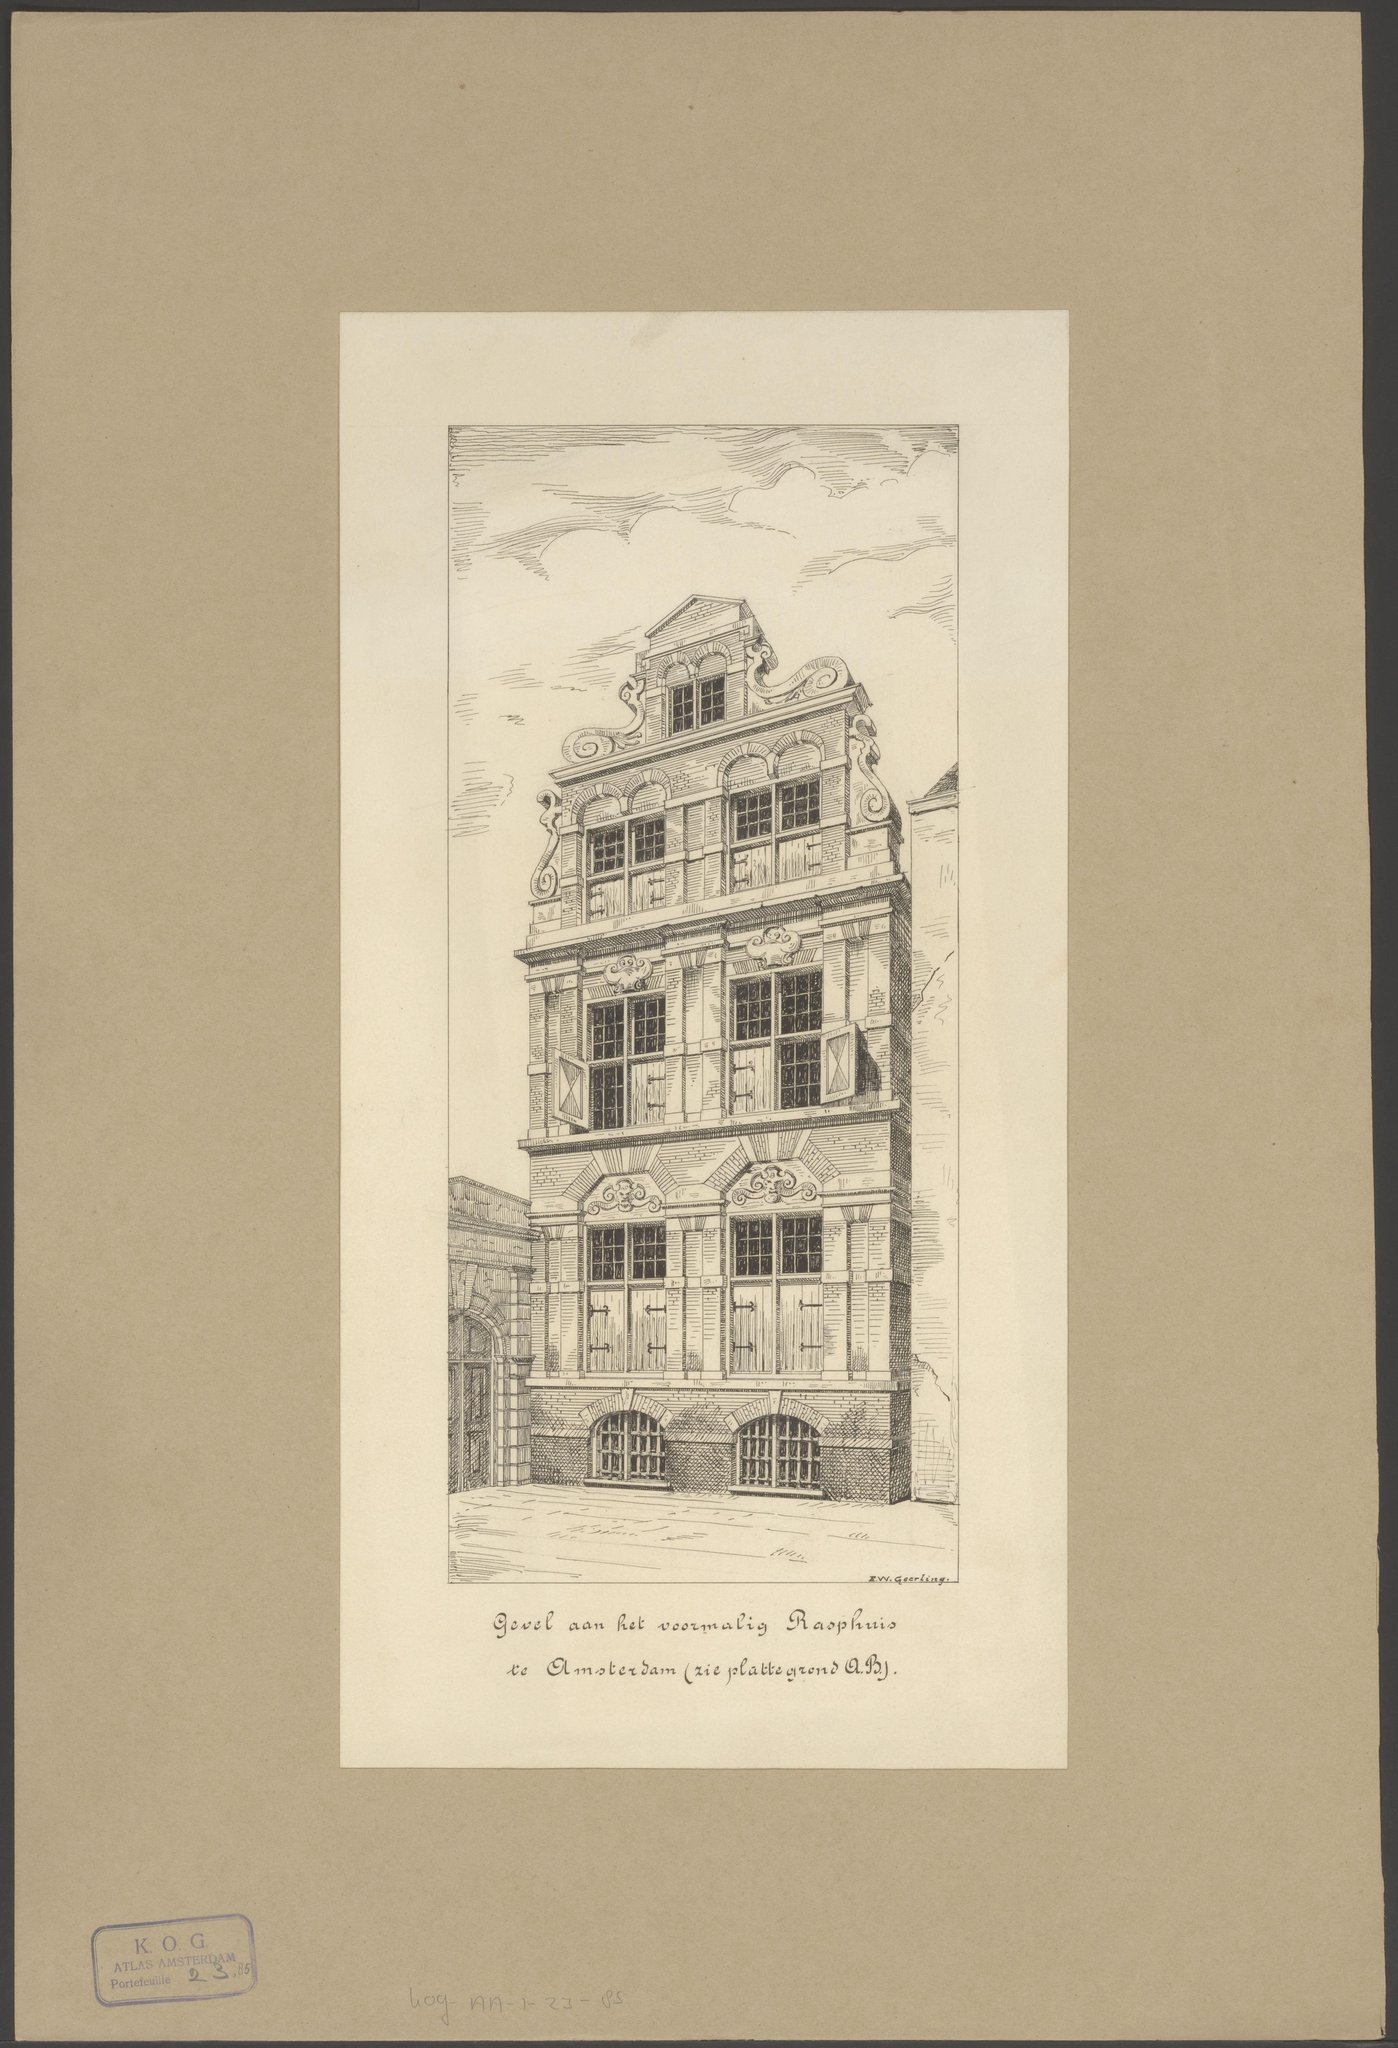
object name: drawing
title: Gevel aan het voormalig Rasphuis te Amsterdam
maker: ernst willem geerling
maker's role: draughtsman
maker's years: 1854-1919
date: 1864-1919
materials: ink, paper, pencil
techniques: pen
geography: amsterdam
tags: prison, jail, rear façade, workhouse, penal camp, penitentiary, chain gang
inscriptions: collector's mark: Lugt 1641b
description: Onderwerpsrubriek binnen de Atlas Amsterdam: Rechtswezen.